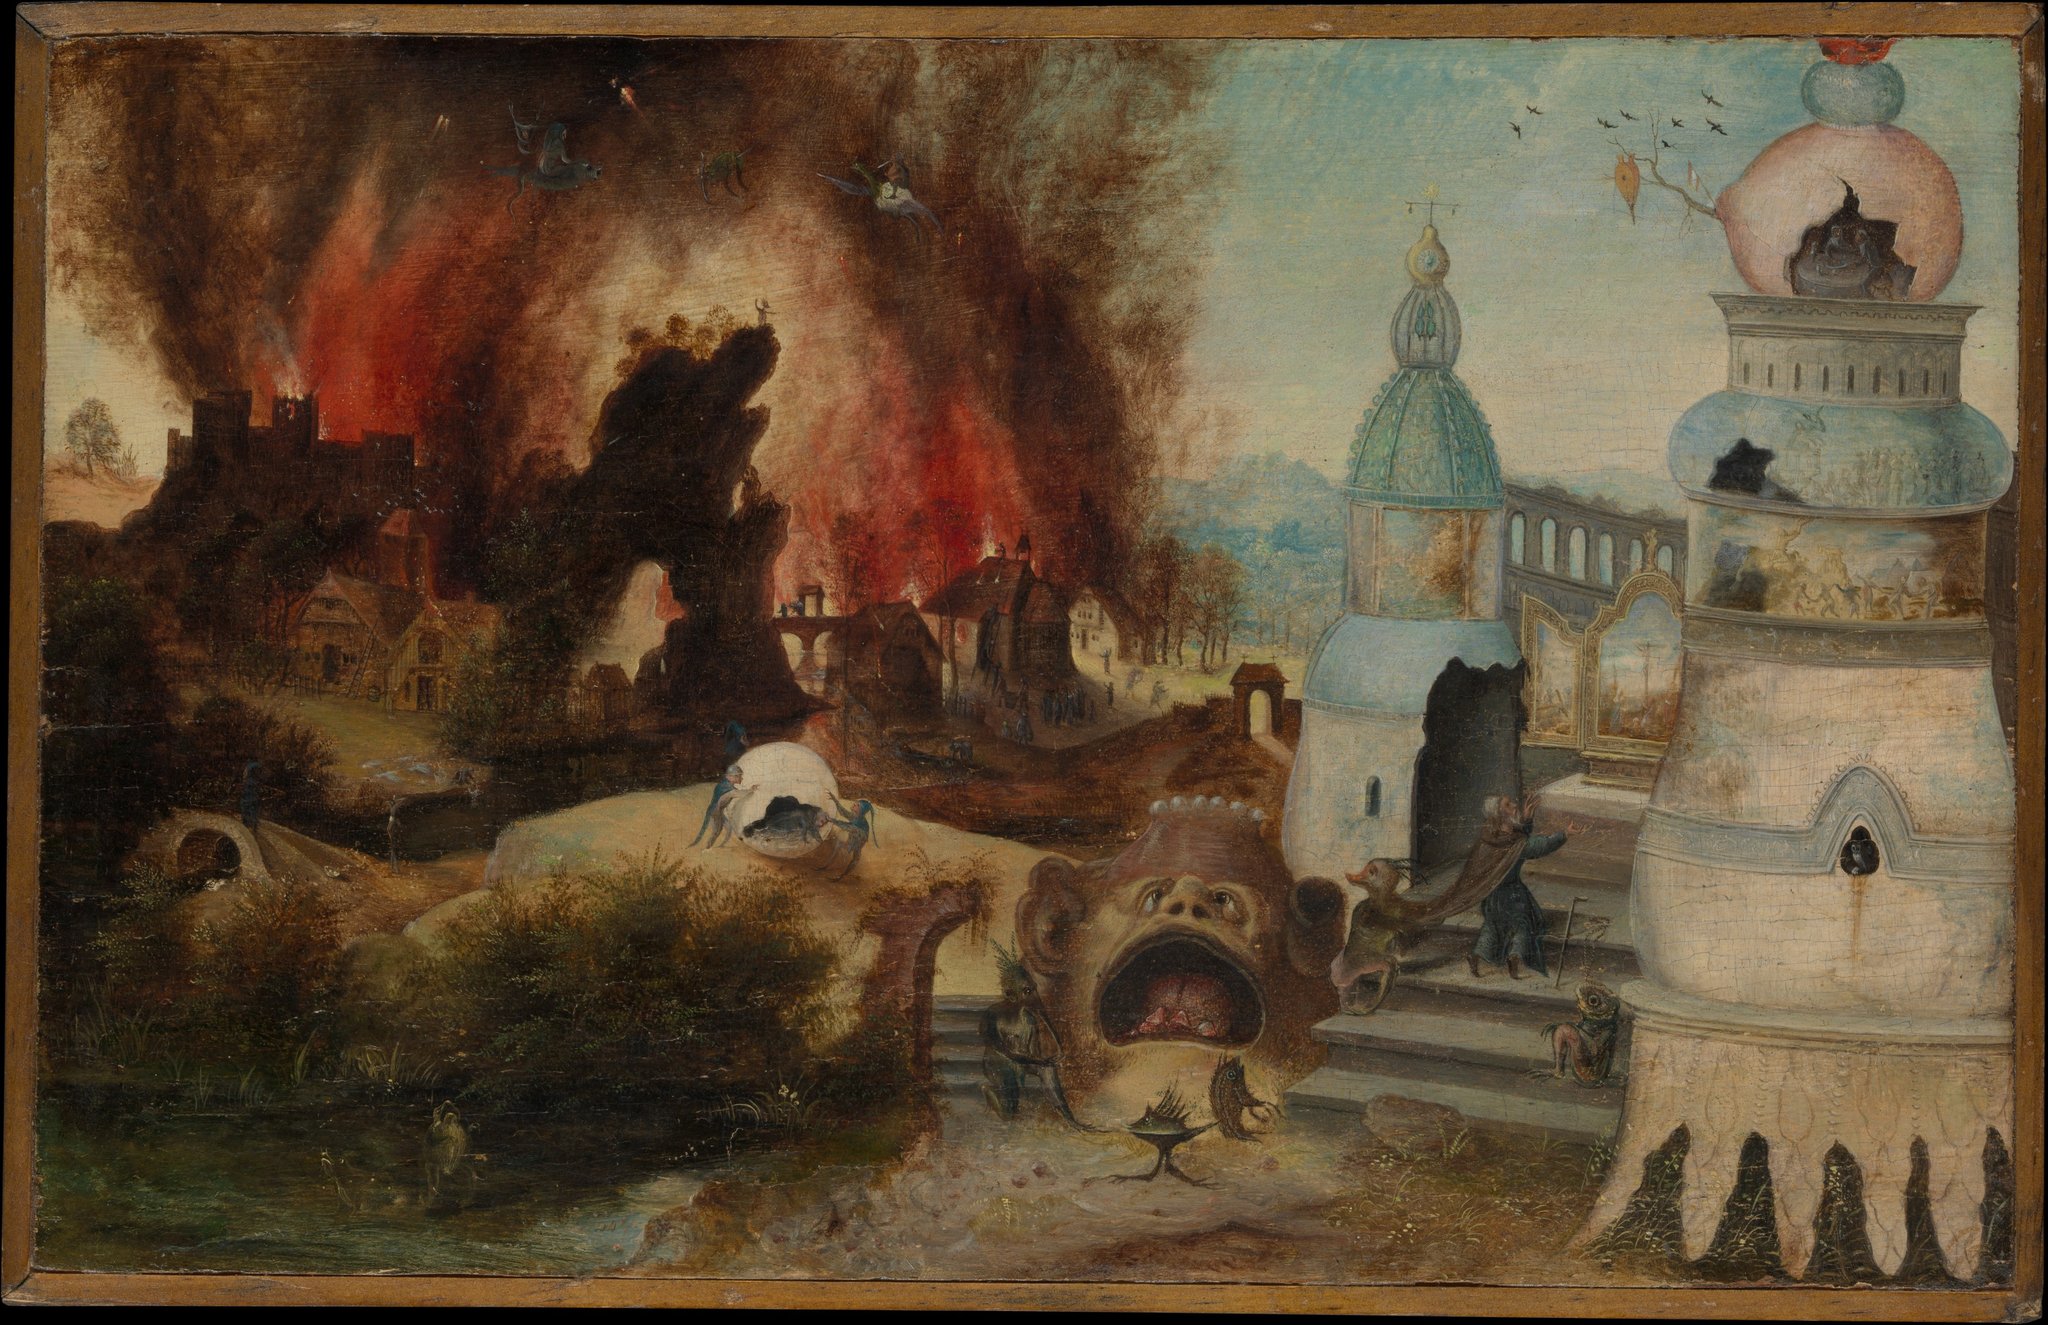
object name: painting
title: The Temptation of Saint Anthony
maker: herri met de bles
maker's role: artist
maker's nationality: netherlandish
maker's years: 1480-1550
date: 1550-1560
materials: oil, wood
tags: fires,saint anthony